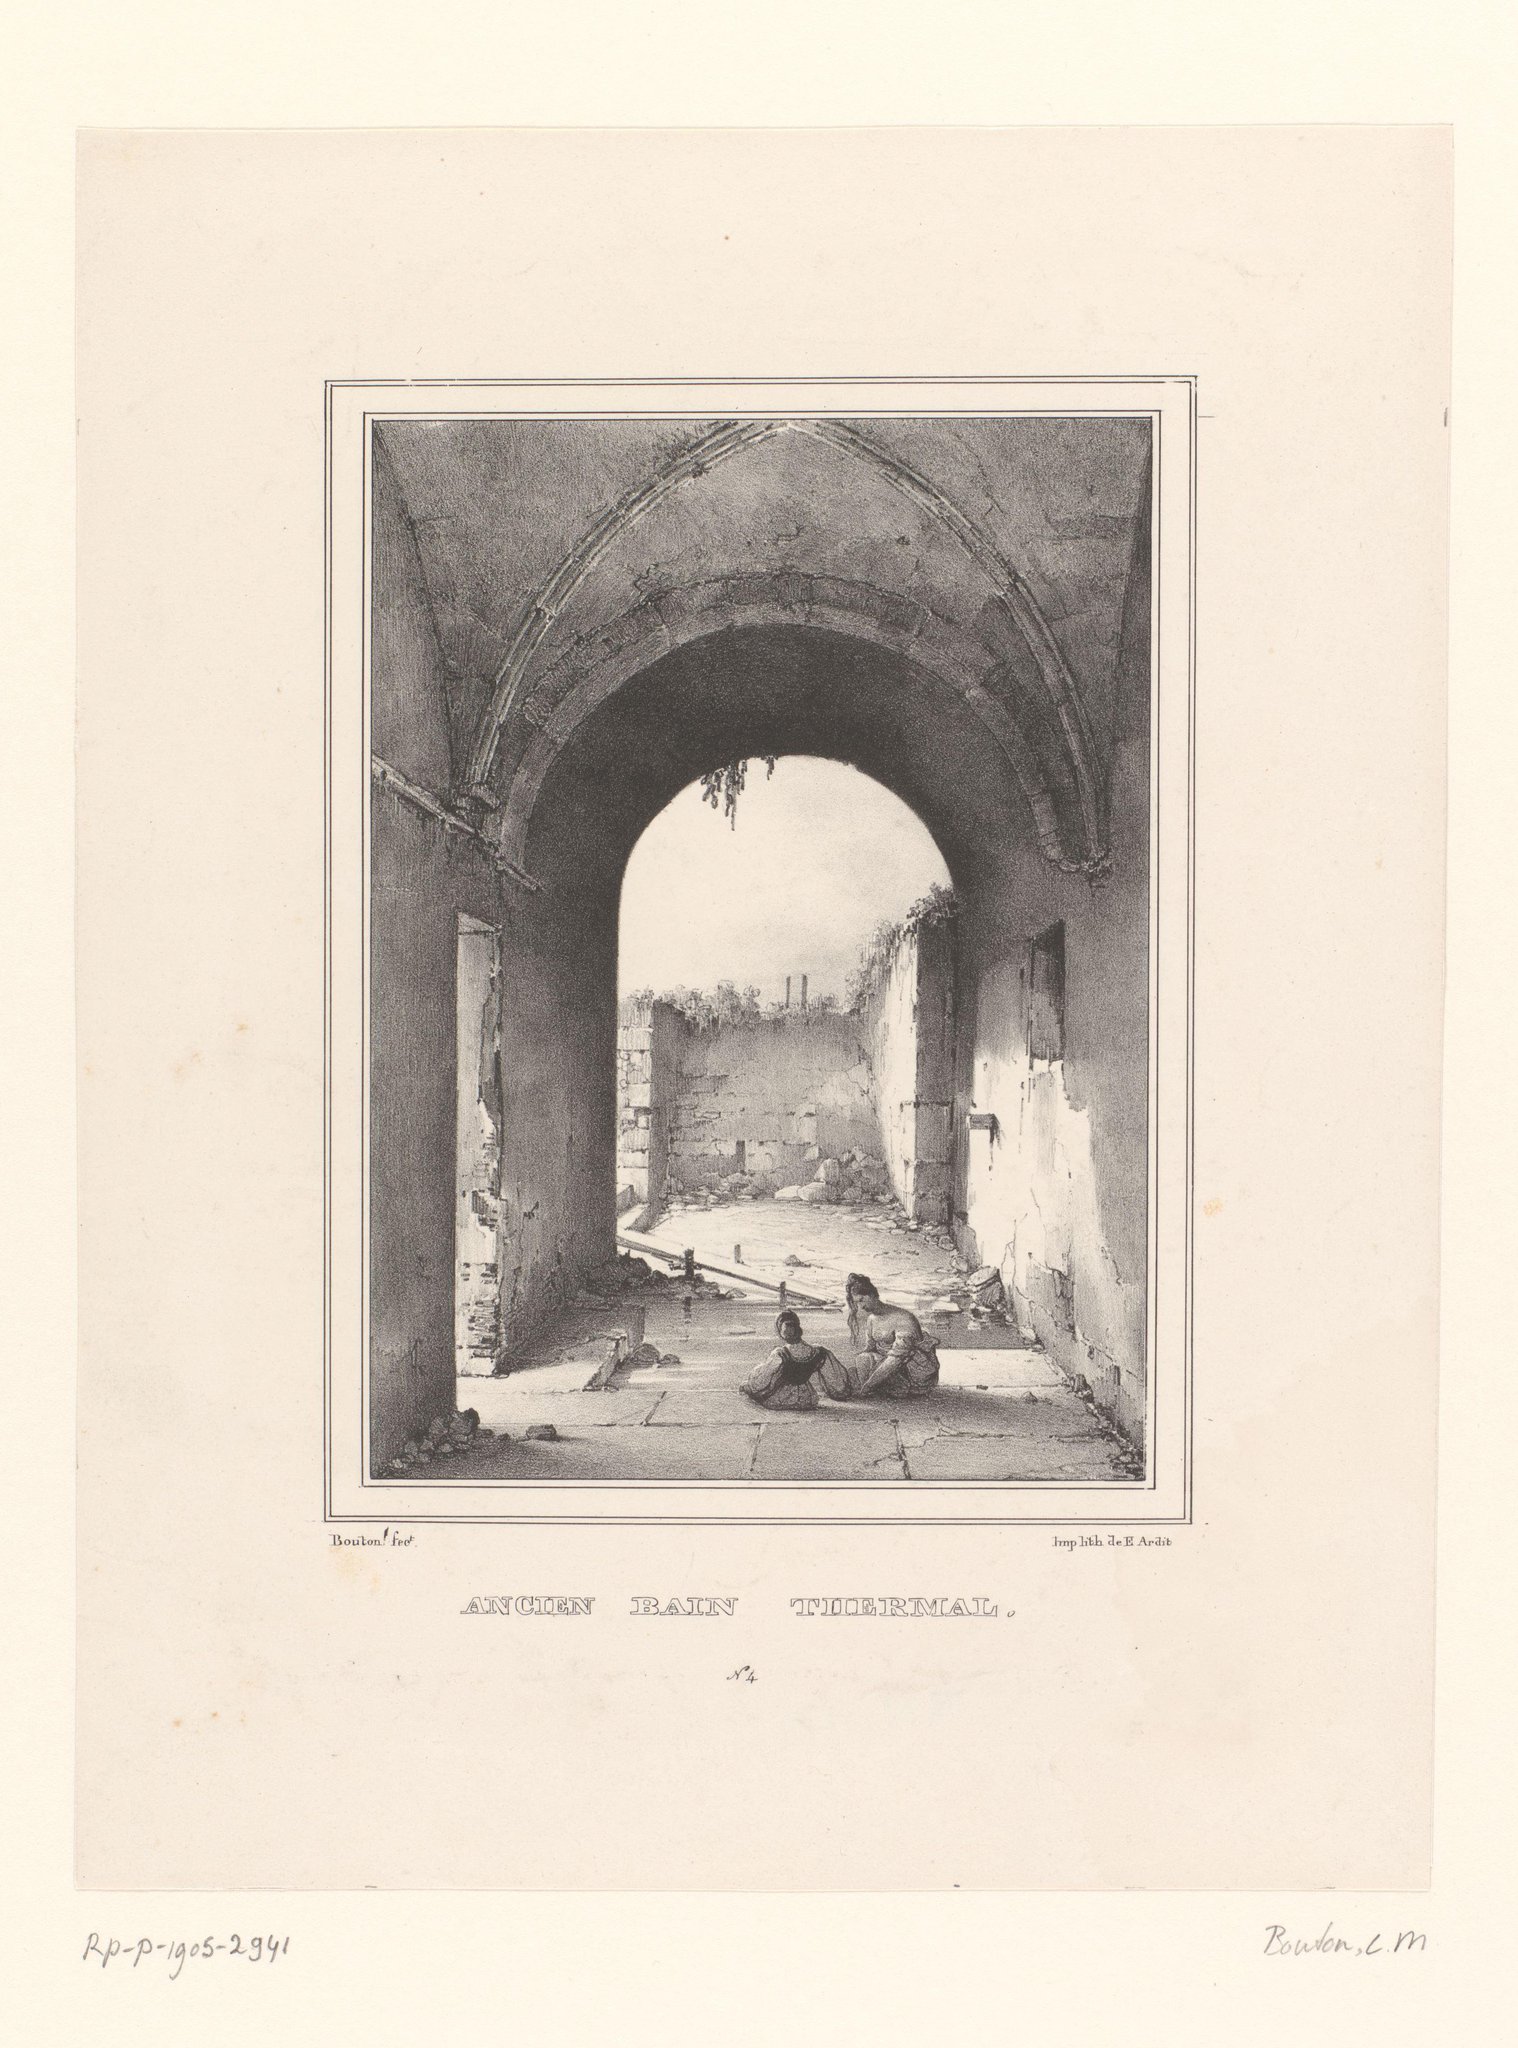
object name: print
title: Ancien bain thermal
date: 1832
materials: paper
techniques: lithograph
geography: paris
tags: ruin of a building ~ architecture, watering-place, spa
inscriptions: collector's mark: Lugt 2228a